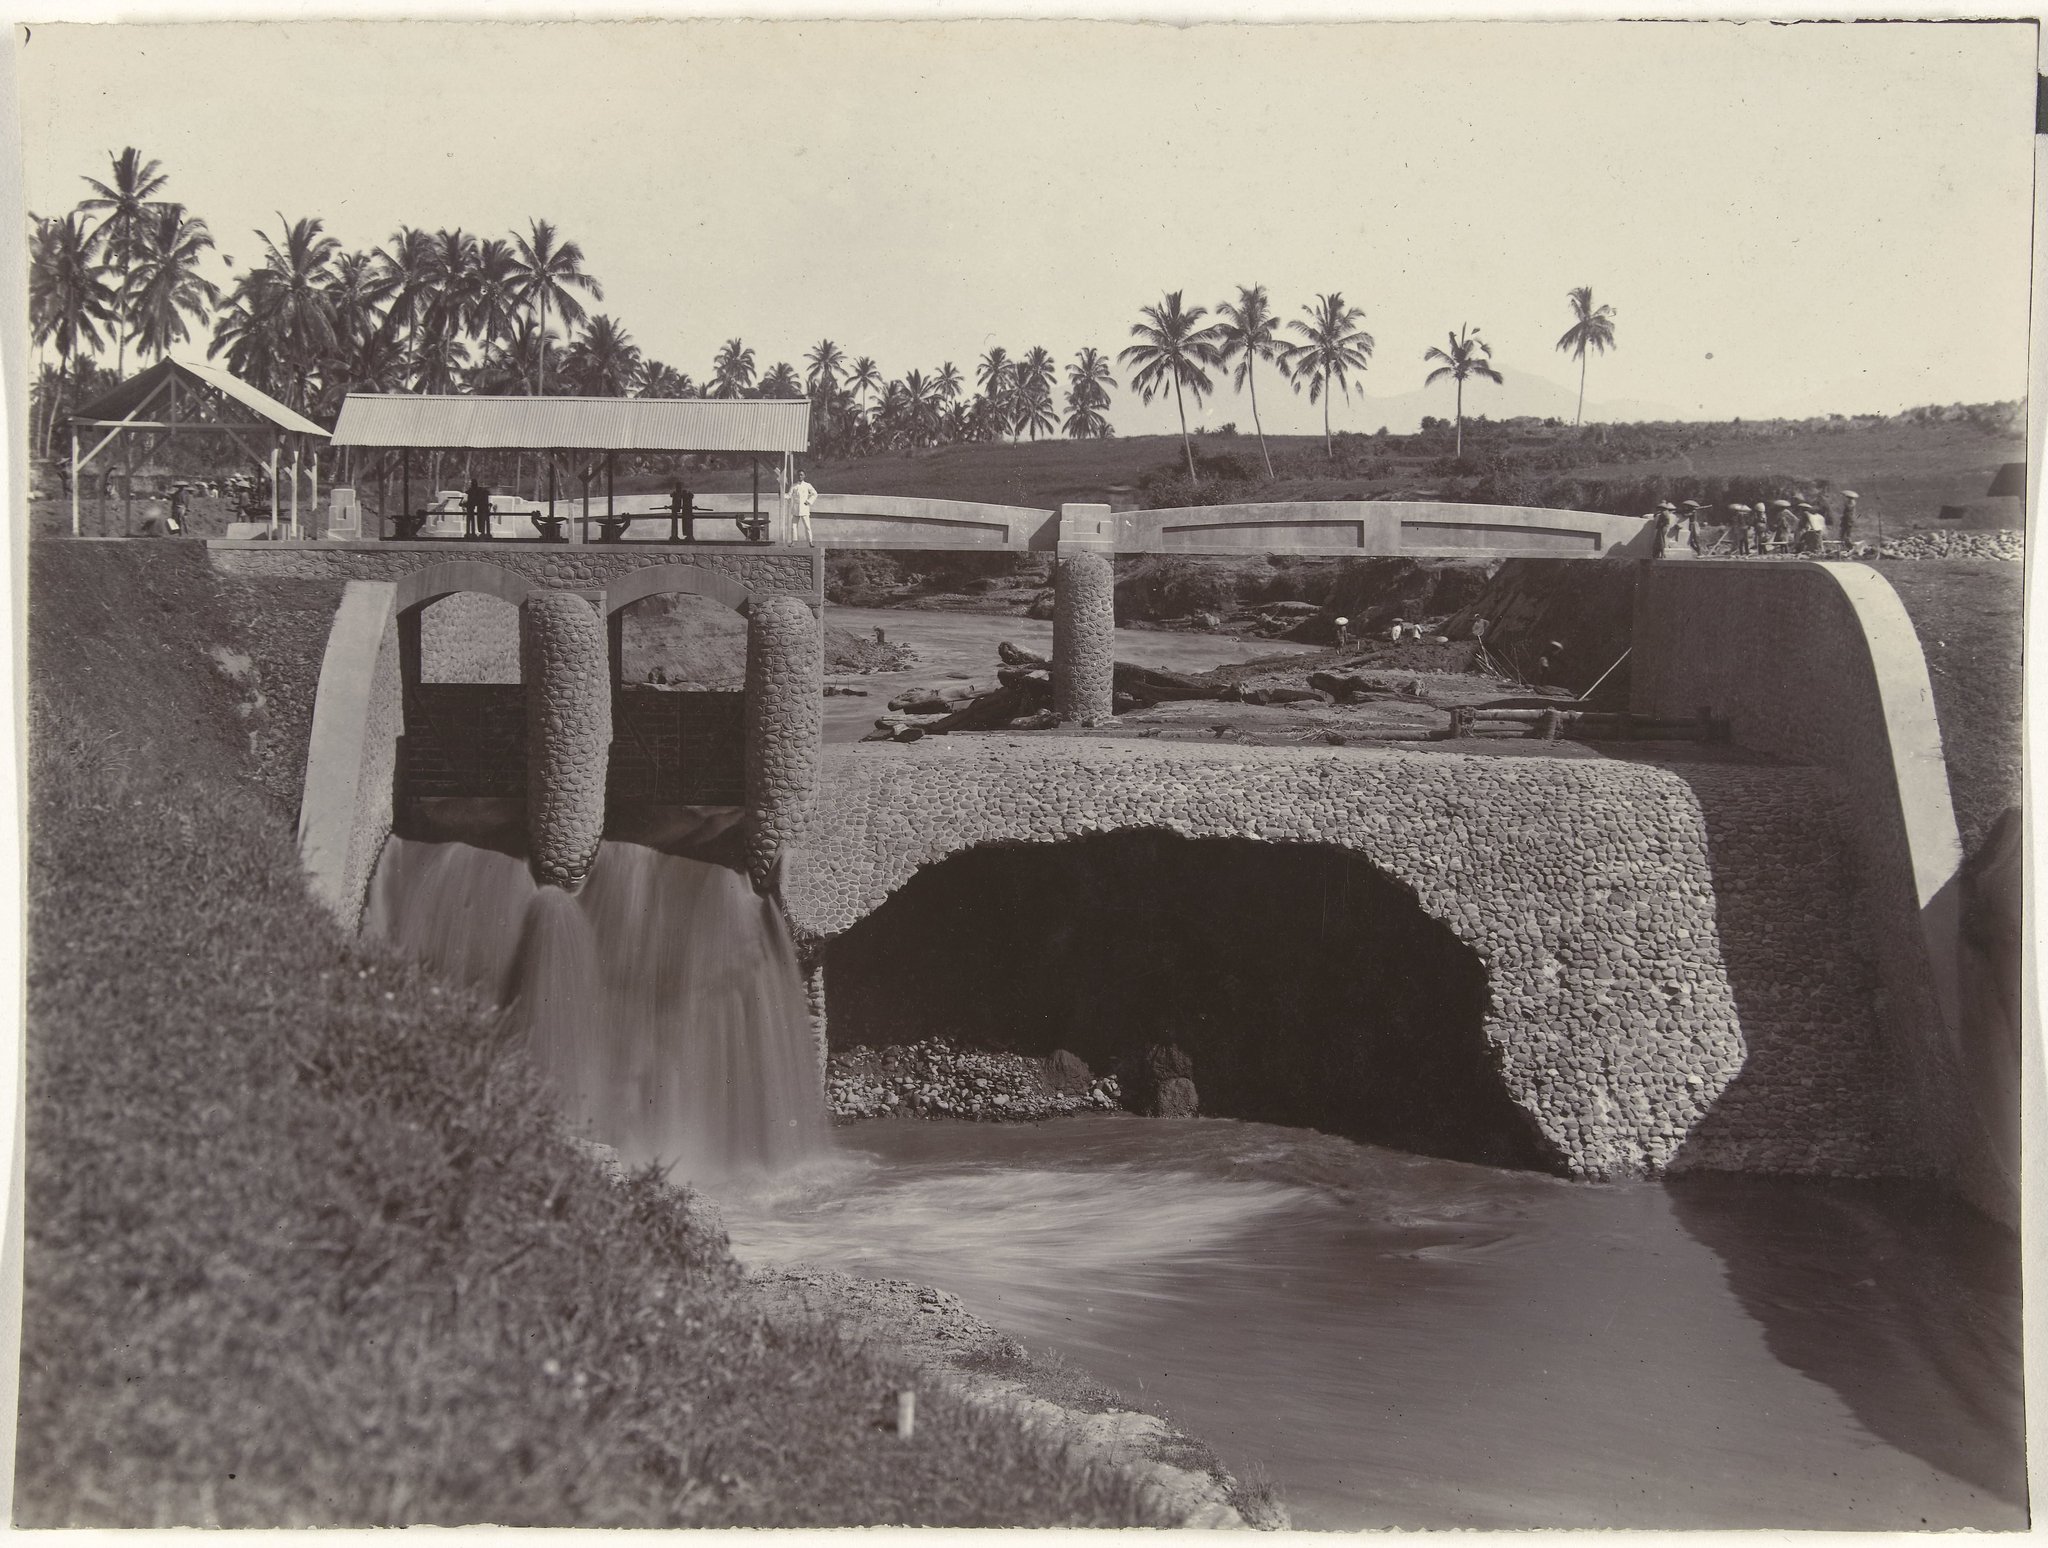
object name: photograph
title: Waterwerken in Nederlands-Indië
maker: Anonymous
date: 1890-1910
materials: paper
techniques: gelatin silver print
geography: indonesia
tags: dam (in canal), indonesia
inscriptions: inscription: ‘Indonesie’